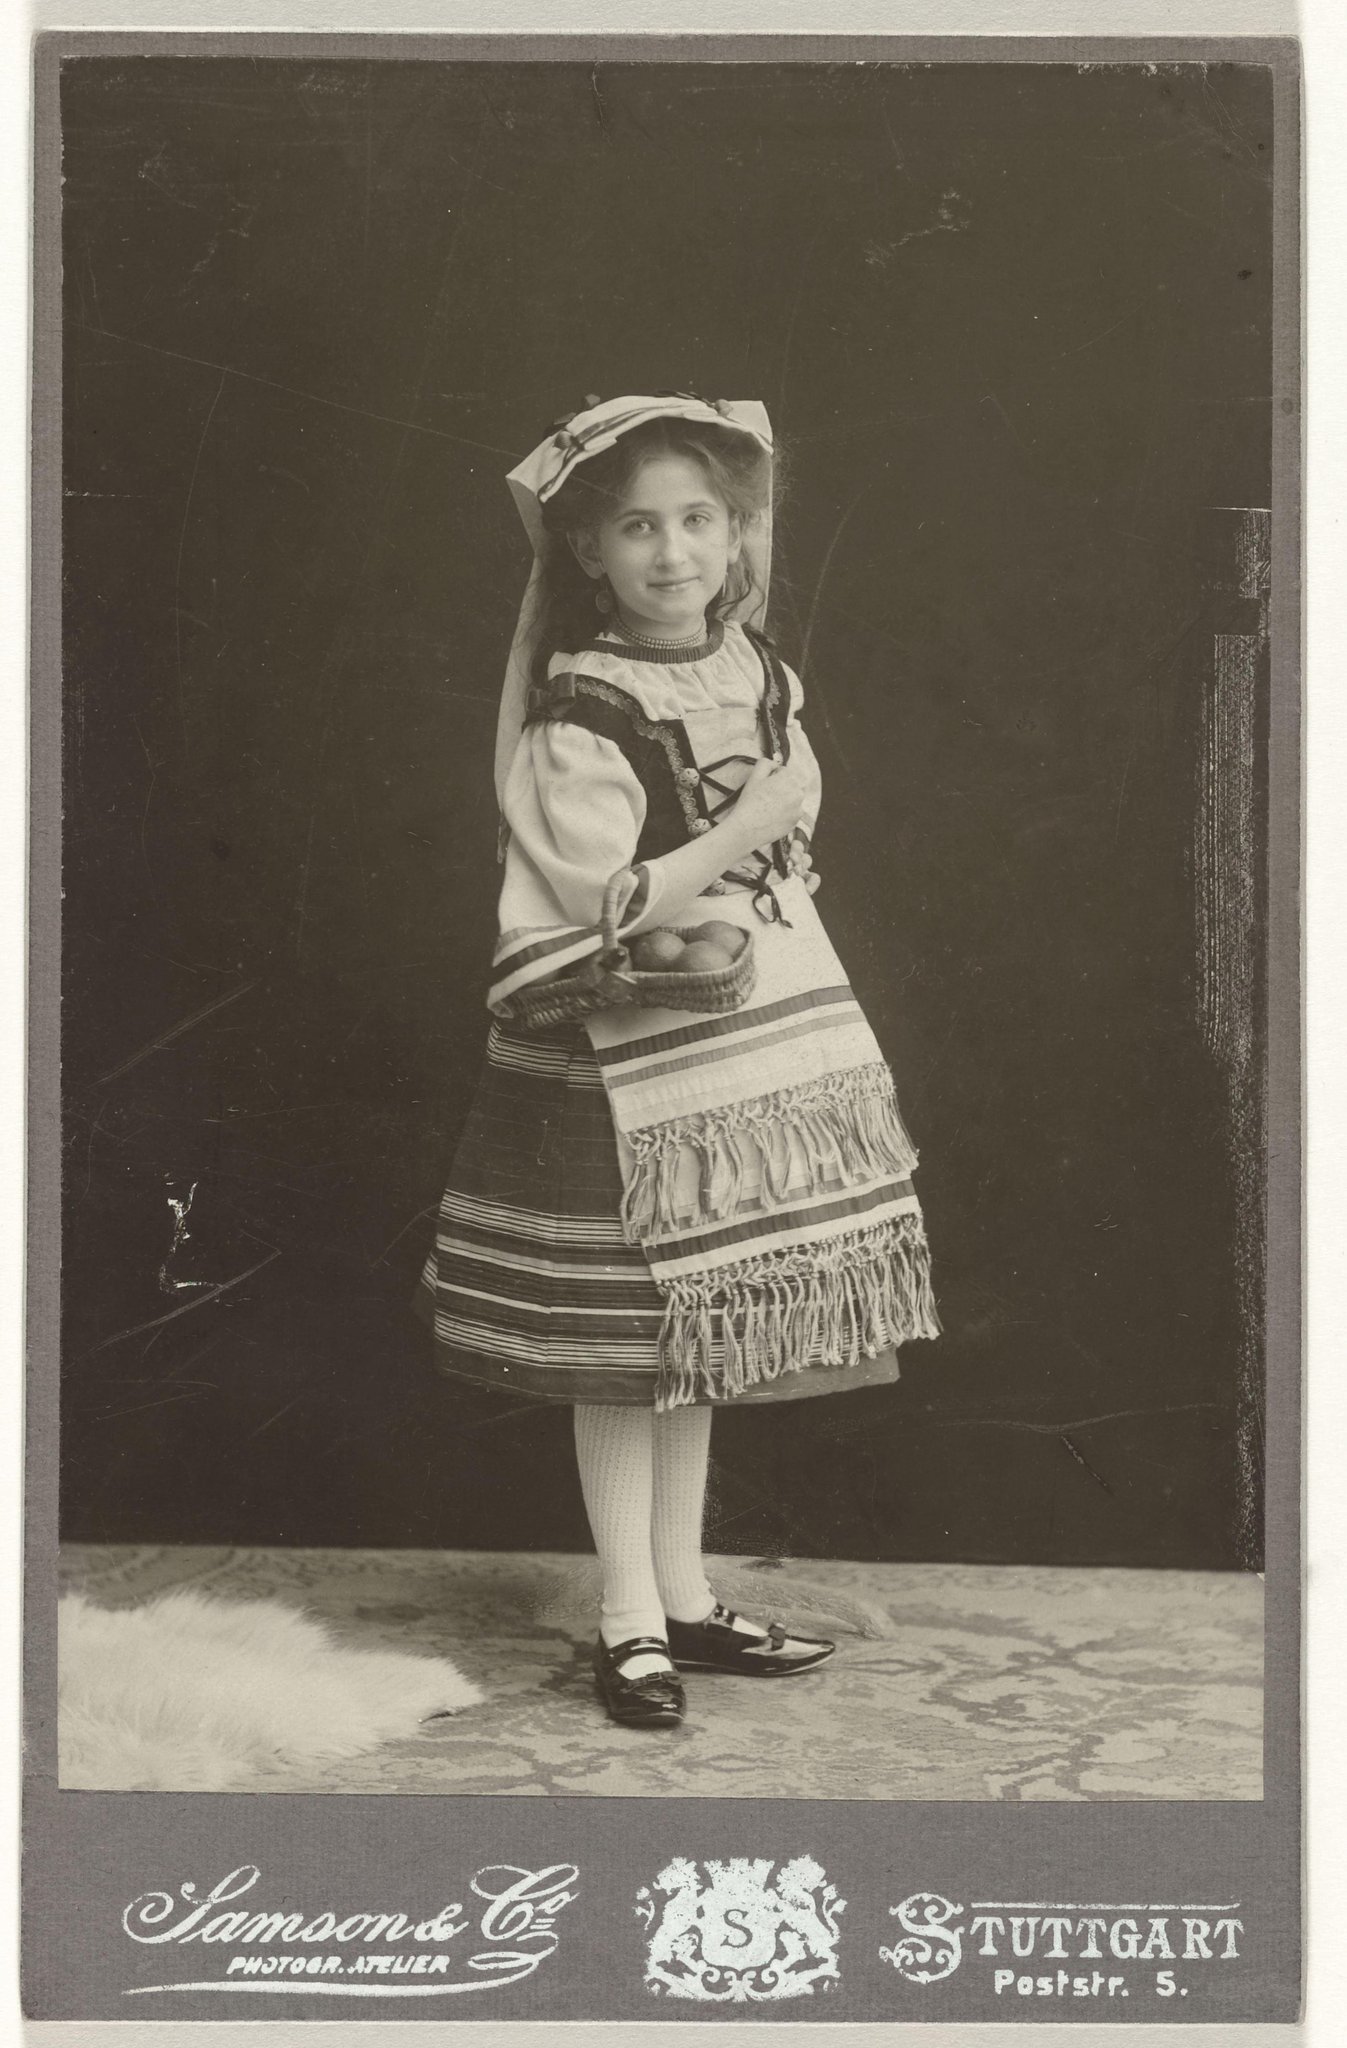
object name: photograph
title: Else Wachenheimer-Moos als jong meisje in zuid-Duitse klederdracht, met een gevuld mandje in haar armen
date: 1891-1901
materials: photographic support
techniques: gelatin silver print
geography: stuttgart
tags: else wachenheimer-moos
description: Else Wachenheimer-Moos als jong meisje in zuid-Duitse klederdracht, met een gevuld mandje in haar armen.